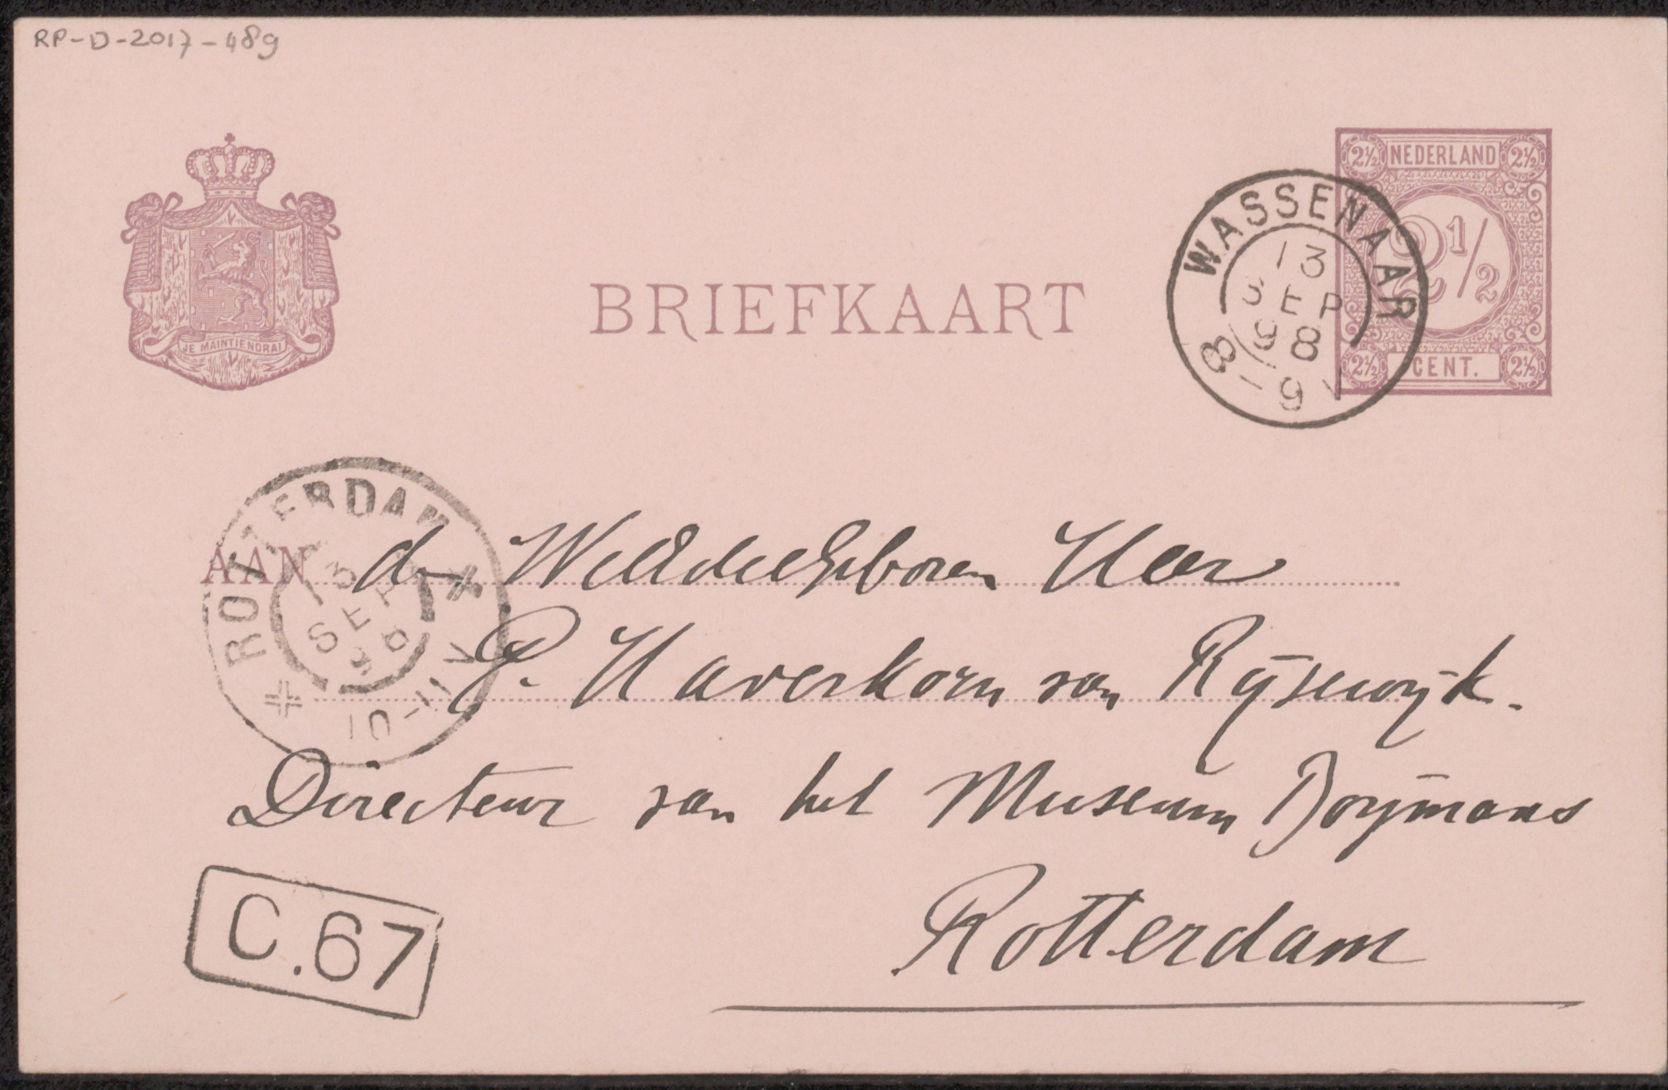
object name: postcard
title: Briefkaart aan Pieter Haverkorn van Rijsewijk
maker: pieter de josselin de jong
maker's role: draughtsman, painter, print maker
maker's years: 1861-1906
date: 1898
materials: cardboard, ink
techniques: pen, writing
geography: wassenaar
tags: pieter haverkorn van rijsewijk, drawing